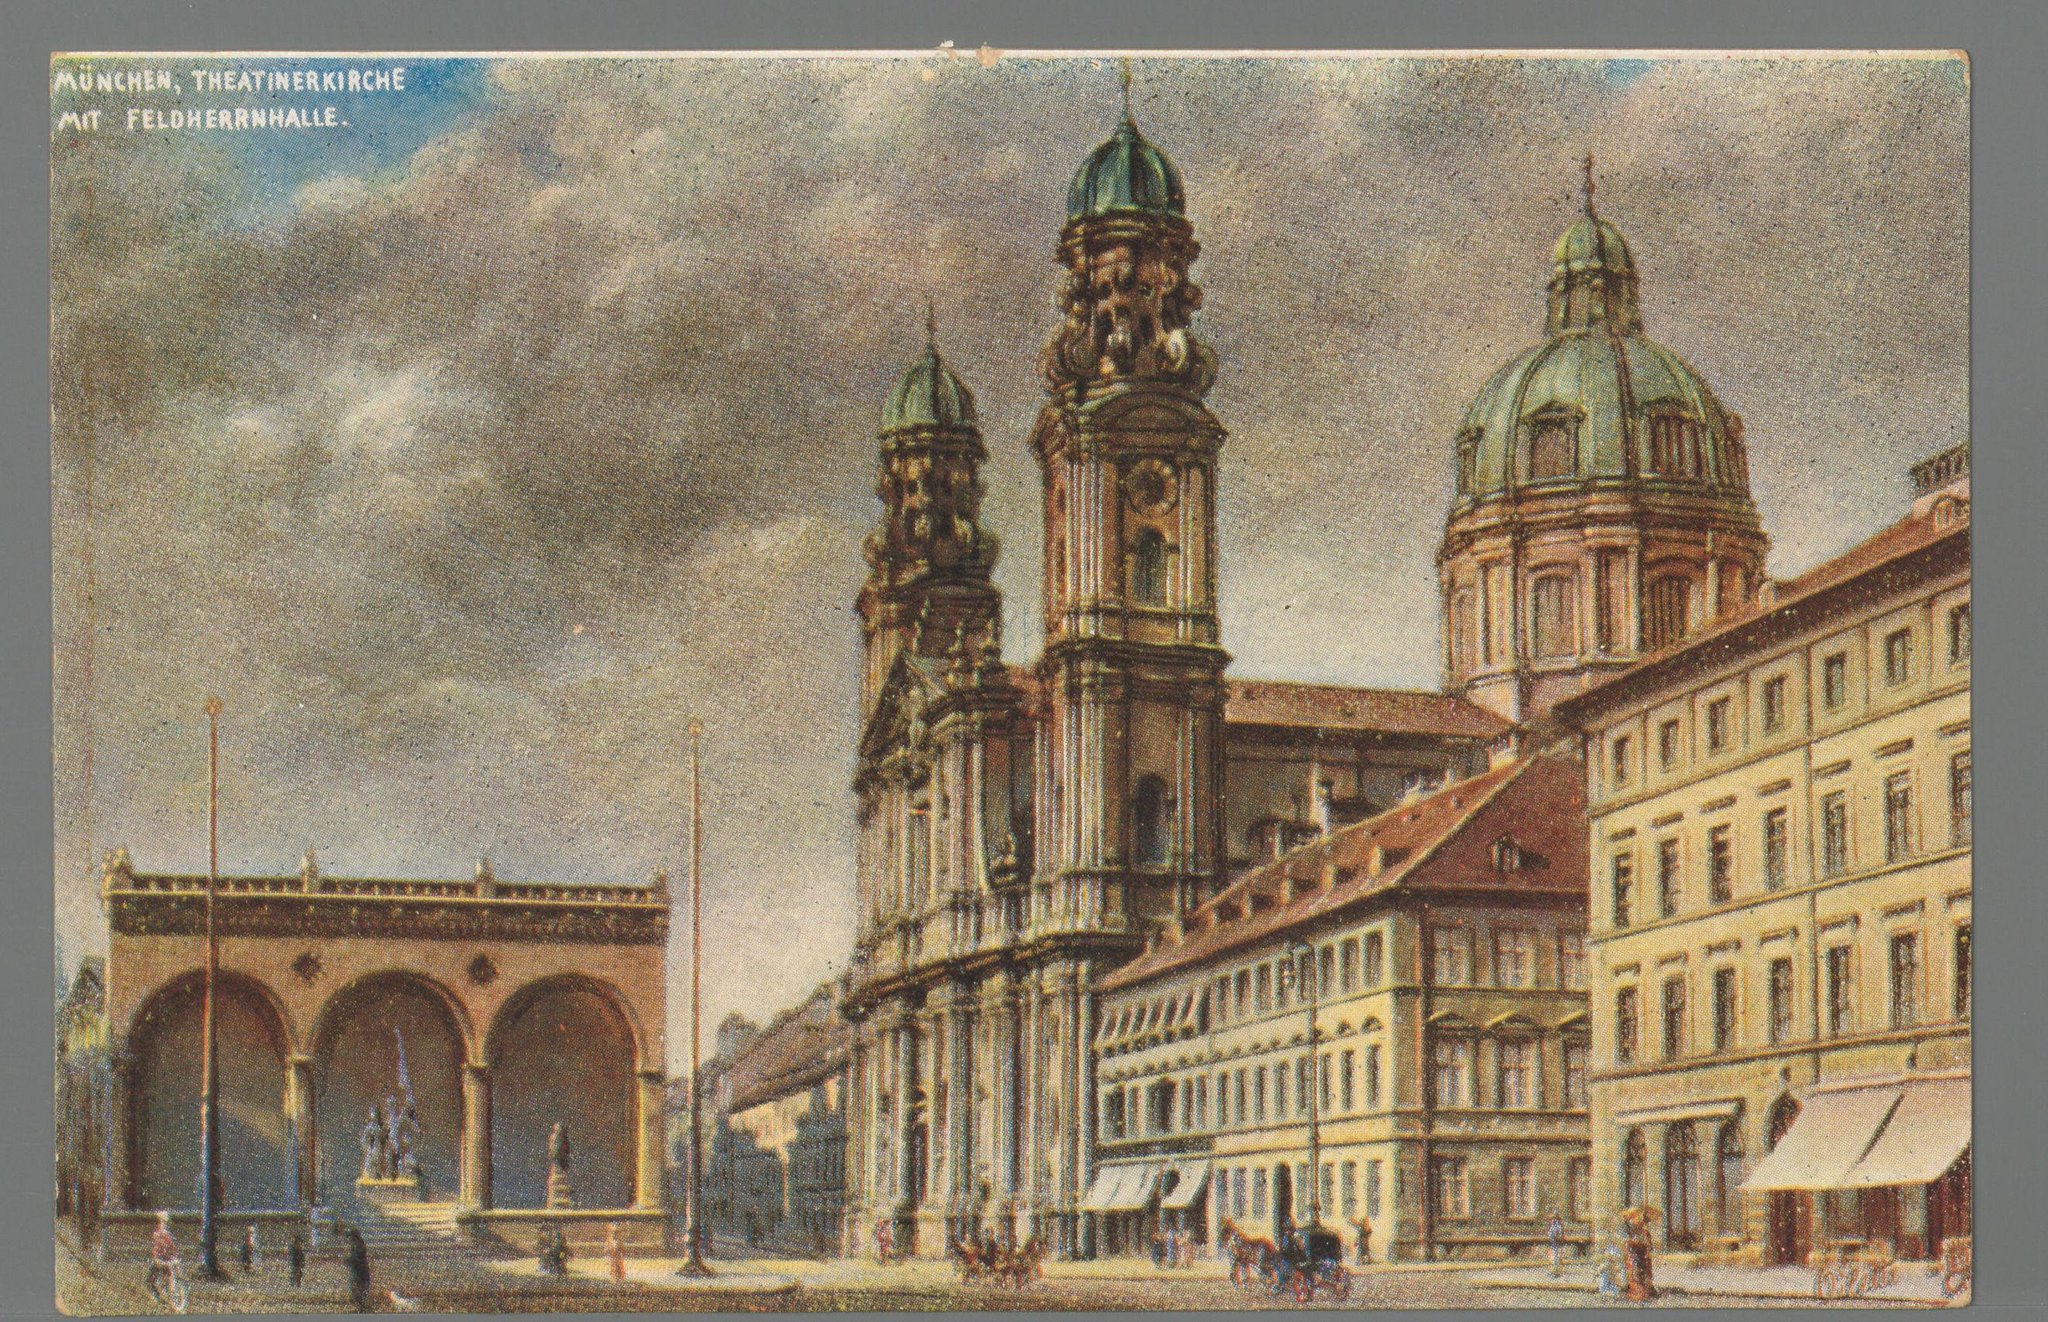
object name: photomechanical print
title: München. Theatinerkirche mit Feldherrnhalle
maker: Anonymous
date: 1906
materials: cardboard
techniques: writing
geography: berlin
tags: church (exterior), loggia, verandah, porch